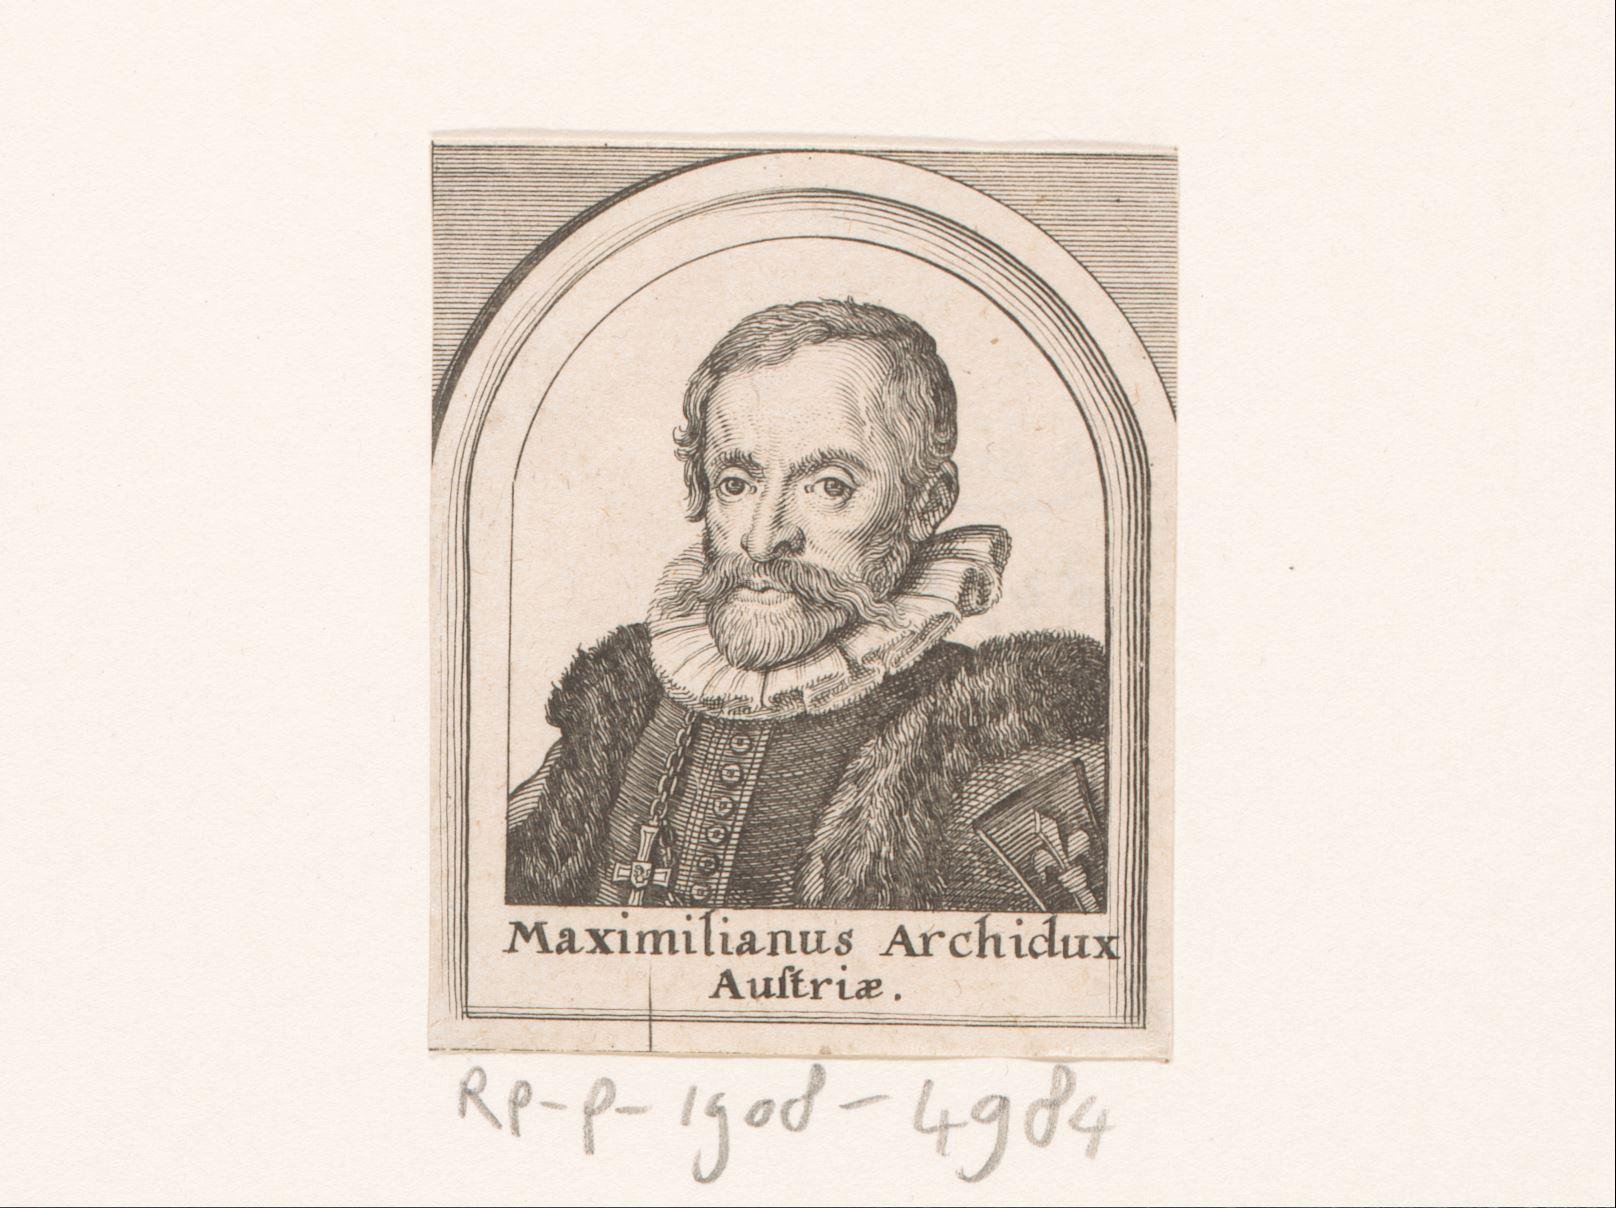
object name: print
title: Maximilianus Archidux Austriae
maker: matthäus merian (i)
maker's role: print maker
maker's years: 1593-1650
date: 1603-1650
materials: paper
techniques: engraving, etching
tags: maximiliaan iii (aartshertog van oostenrijk), fleur-de-lis ~ ornament, historical persons, crucifix ~ personal devotion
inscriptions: collector's mark: Lugt 2228